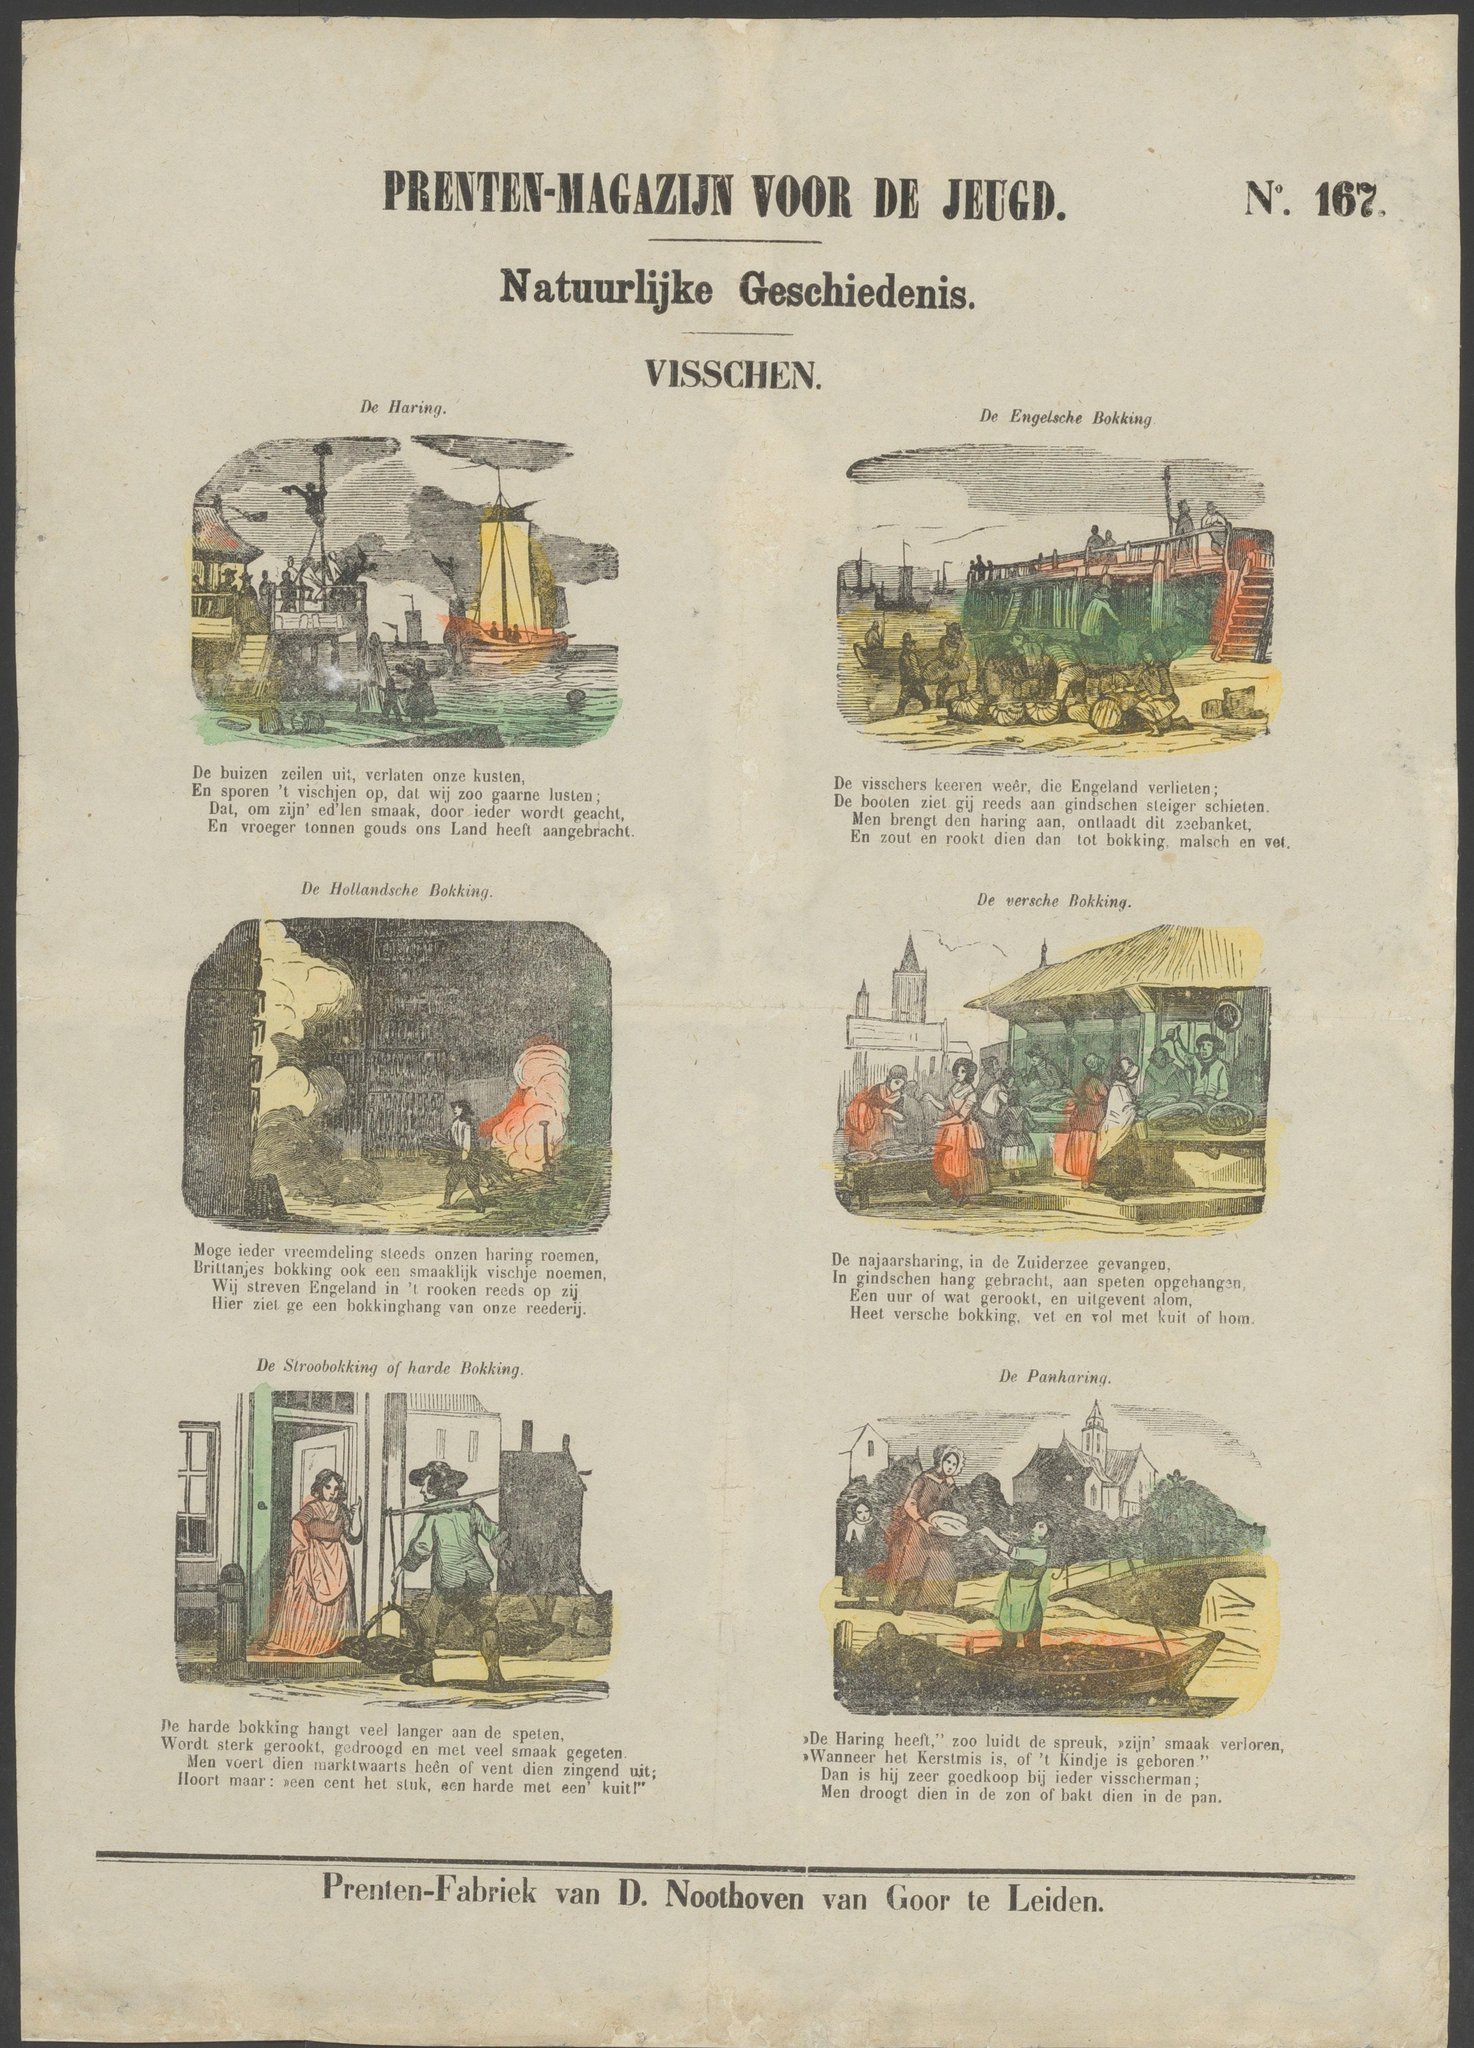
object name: print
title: Vissen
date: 1850-1881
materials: paper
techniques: hand coloring, letterpress printing, engraving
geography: leiden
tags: commercial fishery, street-trader, merchant, salesman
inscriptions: stamp, collector's mark: Lugt 1641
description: Blad met zes voorstellingen over het vangen en het verkopen van vis. Boven elke voorstelling een titel en onder elke voorstelling een vierregelig vers. Genummerd rechtsboven: No. 167. Onderwerpsrubrieken binnen de Atlas Zeden en Gewoonten: Zeden en Gewoonten in Engeren Zin, Des menschen beging, midden en einde, Kinderleven – Kinderspel en Kinderprenten.